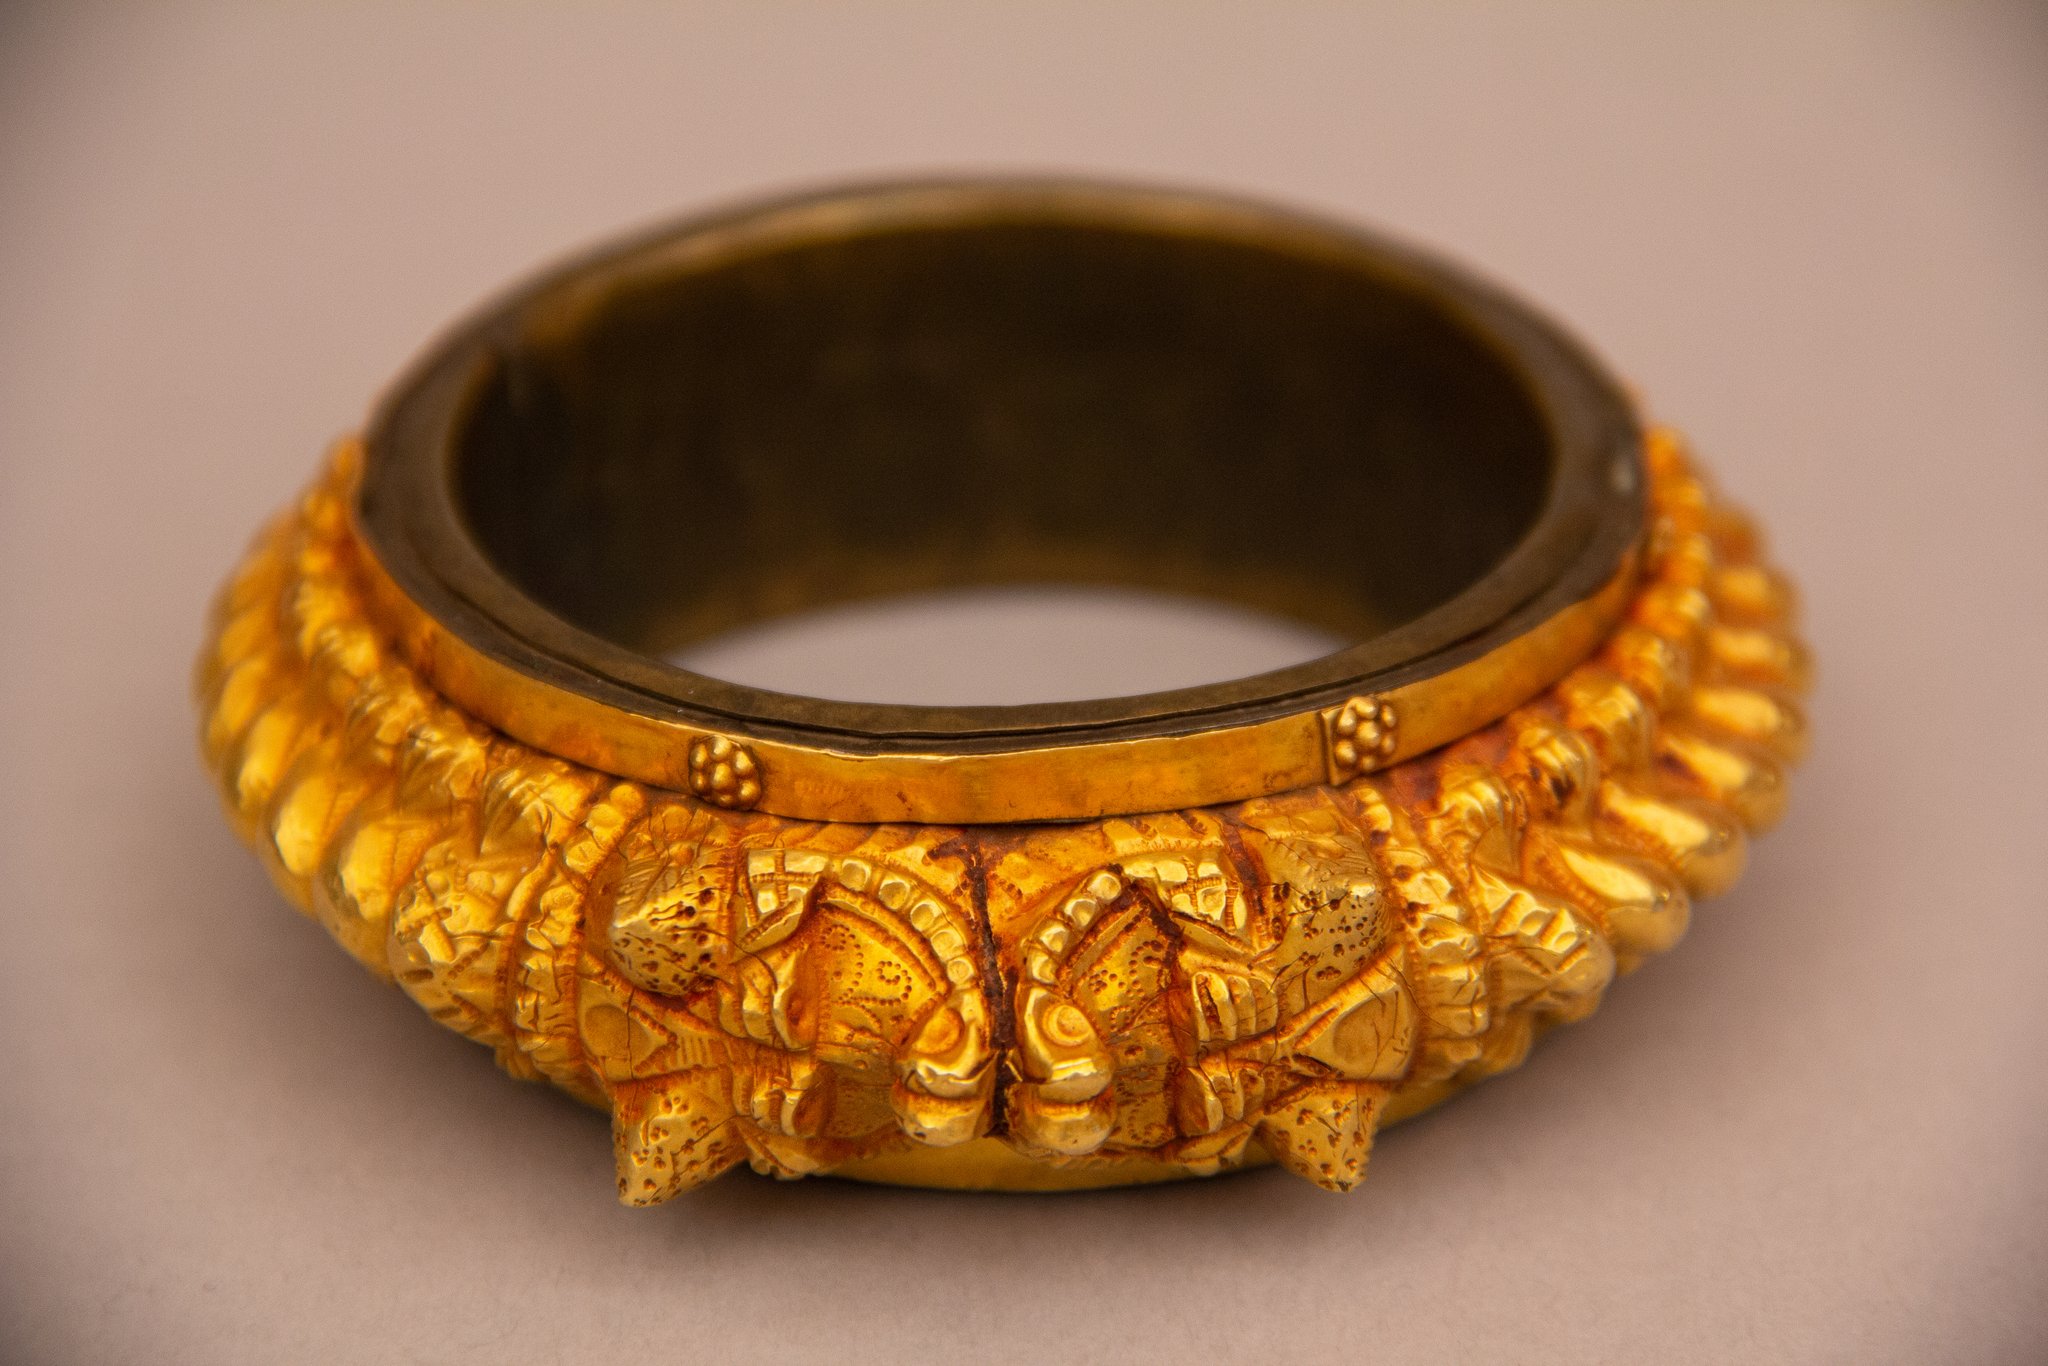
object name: bracelet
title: Bracelet (Kada)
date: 1801-1900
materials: gold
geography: central india